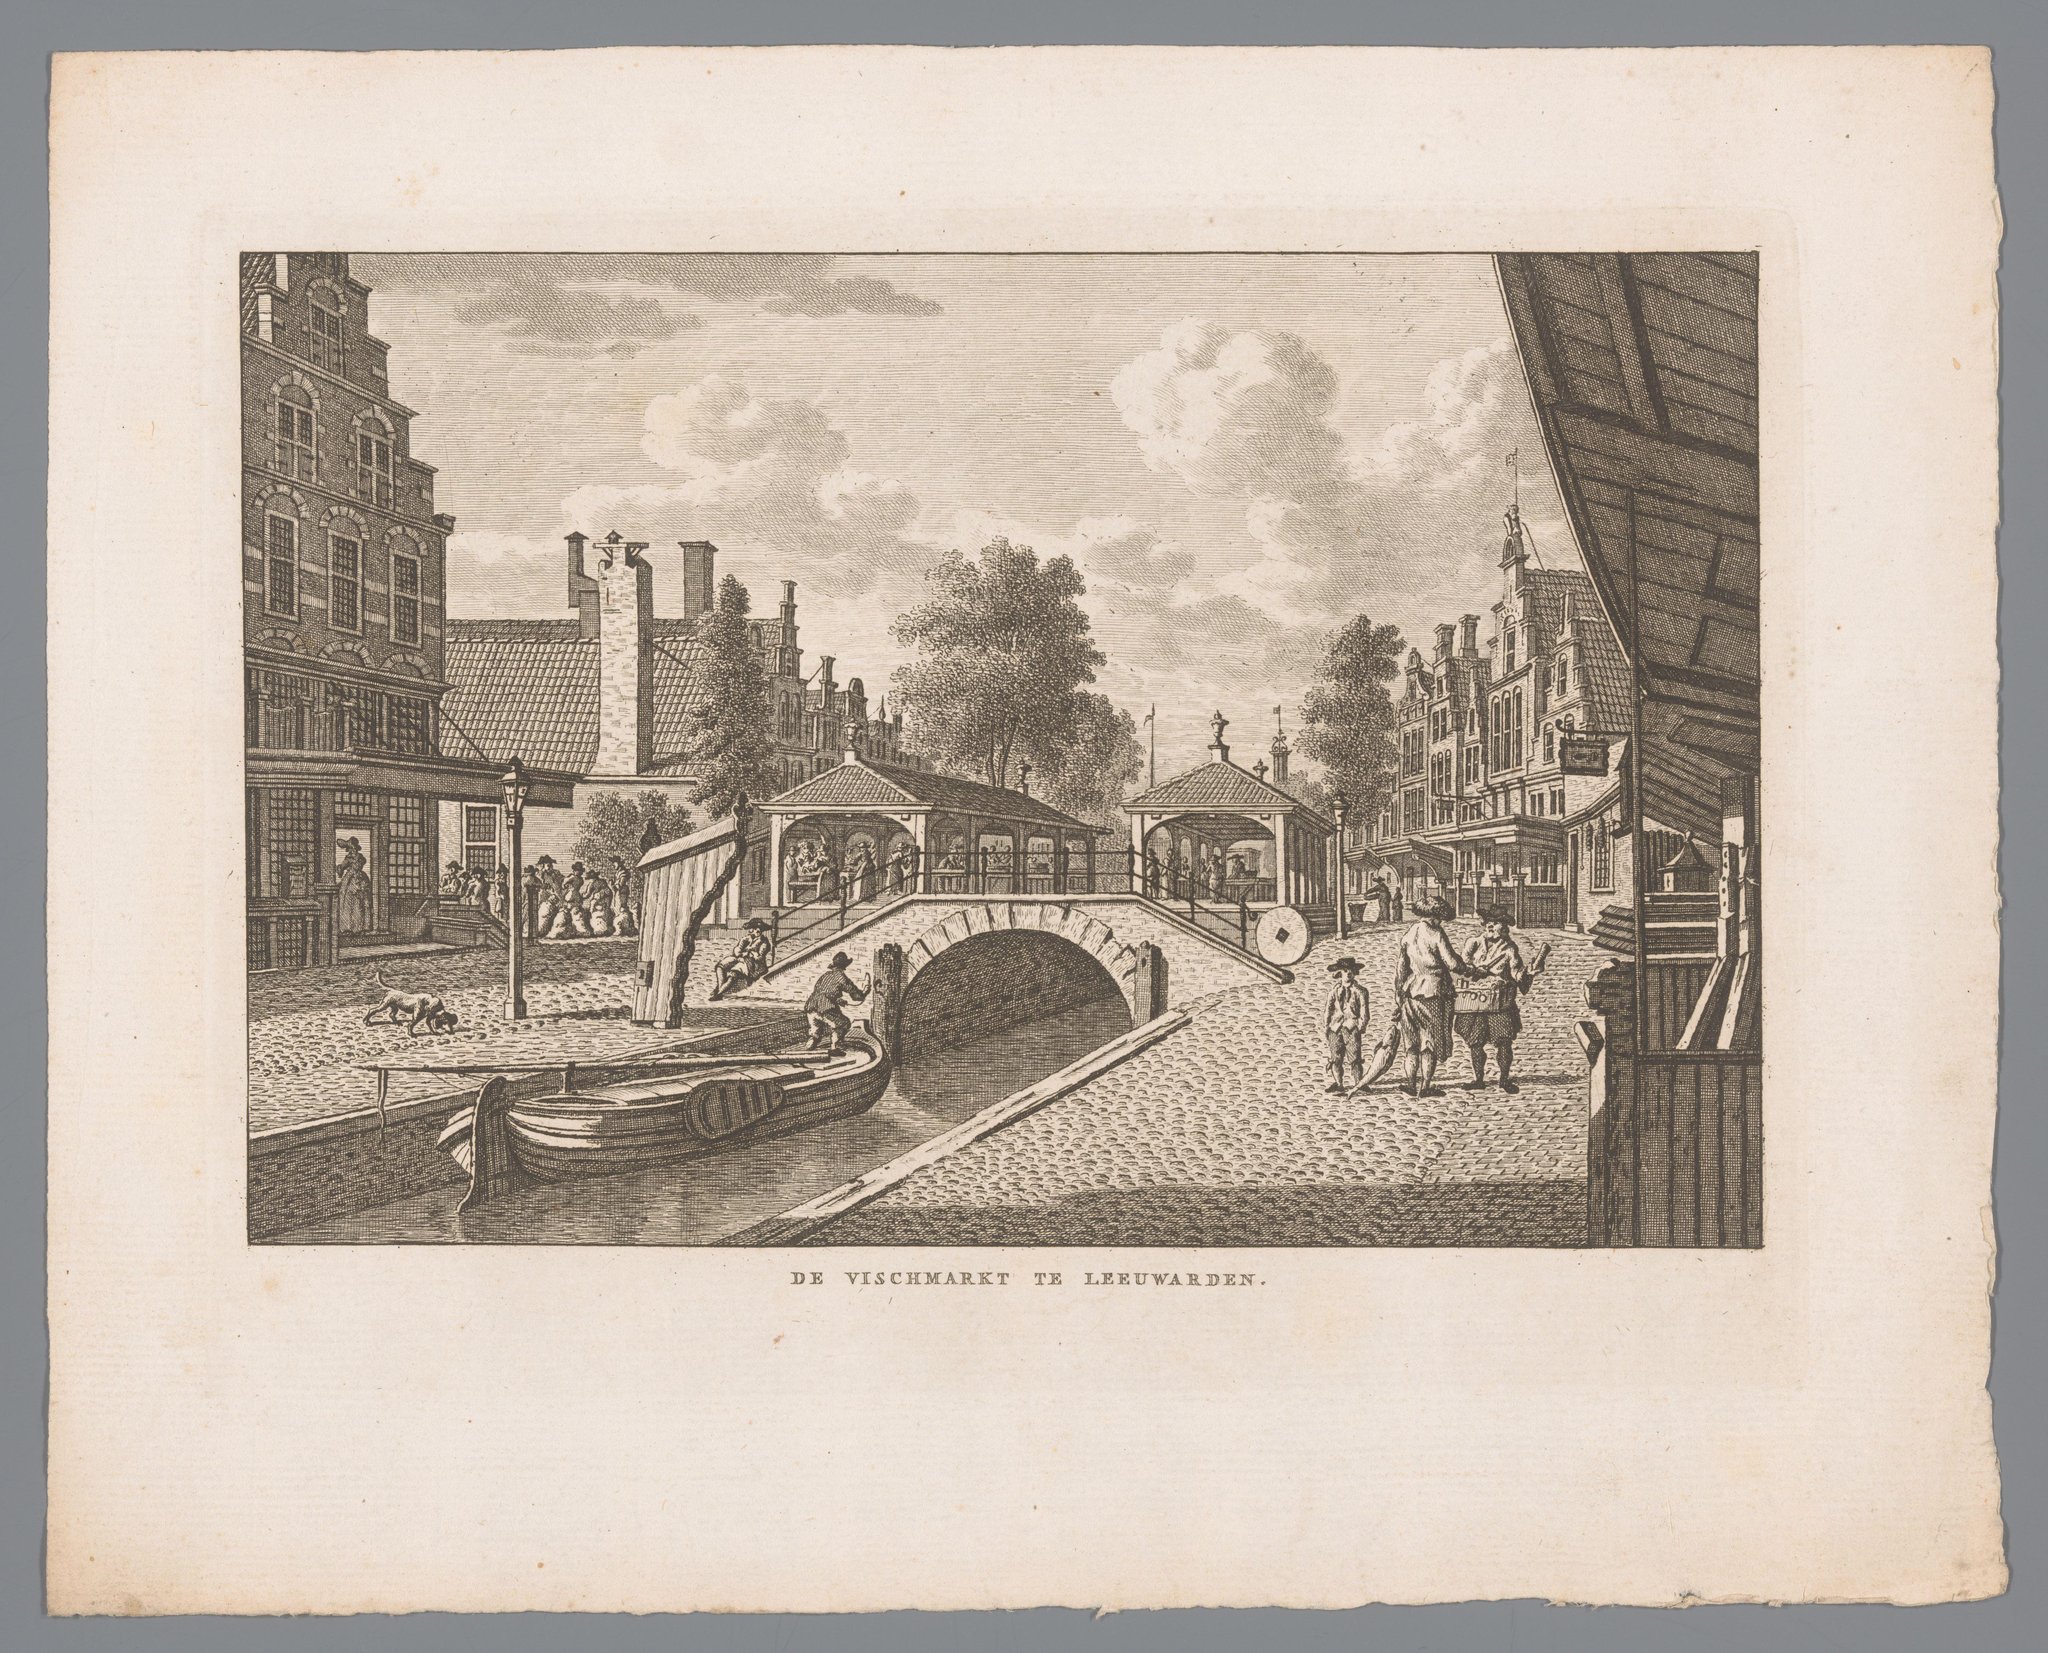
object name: print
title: Vismarkt te Leeuwarden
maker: carel frederik bendorp (i)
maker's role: print maker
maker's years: 1736-1814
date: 1786-1792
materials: paper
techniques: etching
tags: village, market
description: Prent uit: Vaderlandsche gezichten, of afbeeldingen van den tegenwoordigen staat der Vereenigde Nederlanden (…). Amsterdam: Hendrik Gartman, Willem Vermandel en Jan Willem Smit, 1786-1792. Uitgegeven in afleveringen met ieder een eigen bifolium en inhoudsopgave. Alle prenten in deze publicatie zijn gegraveerd door Carel Frederik Bendorp (I) en, in de meeste gevallen, gebaseerd op tekeningen van Jan Bulthuis.